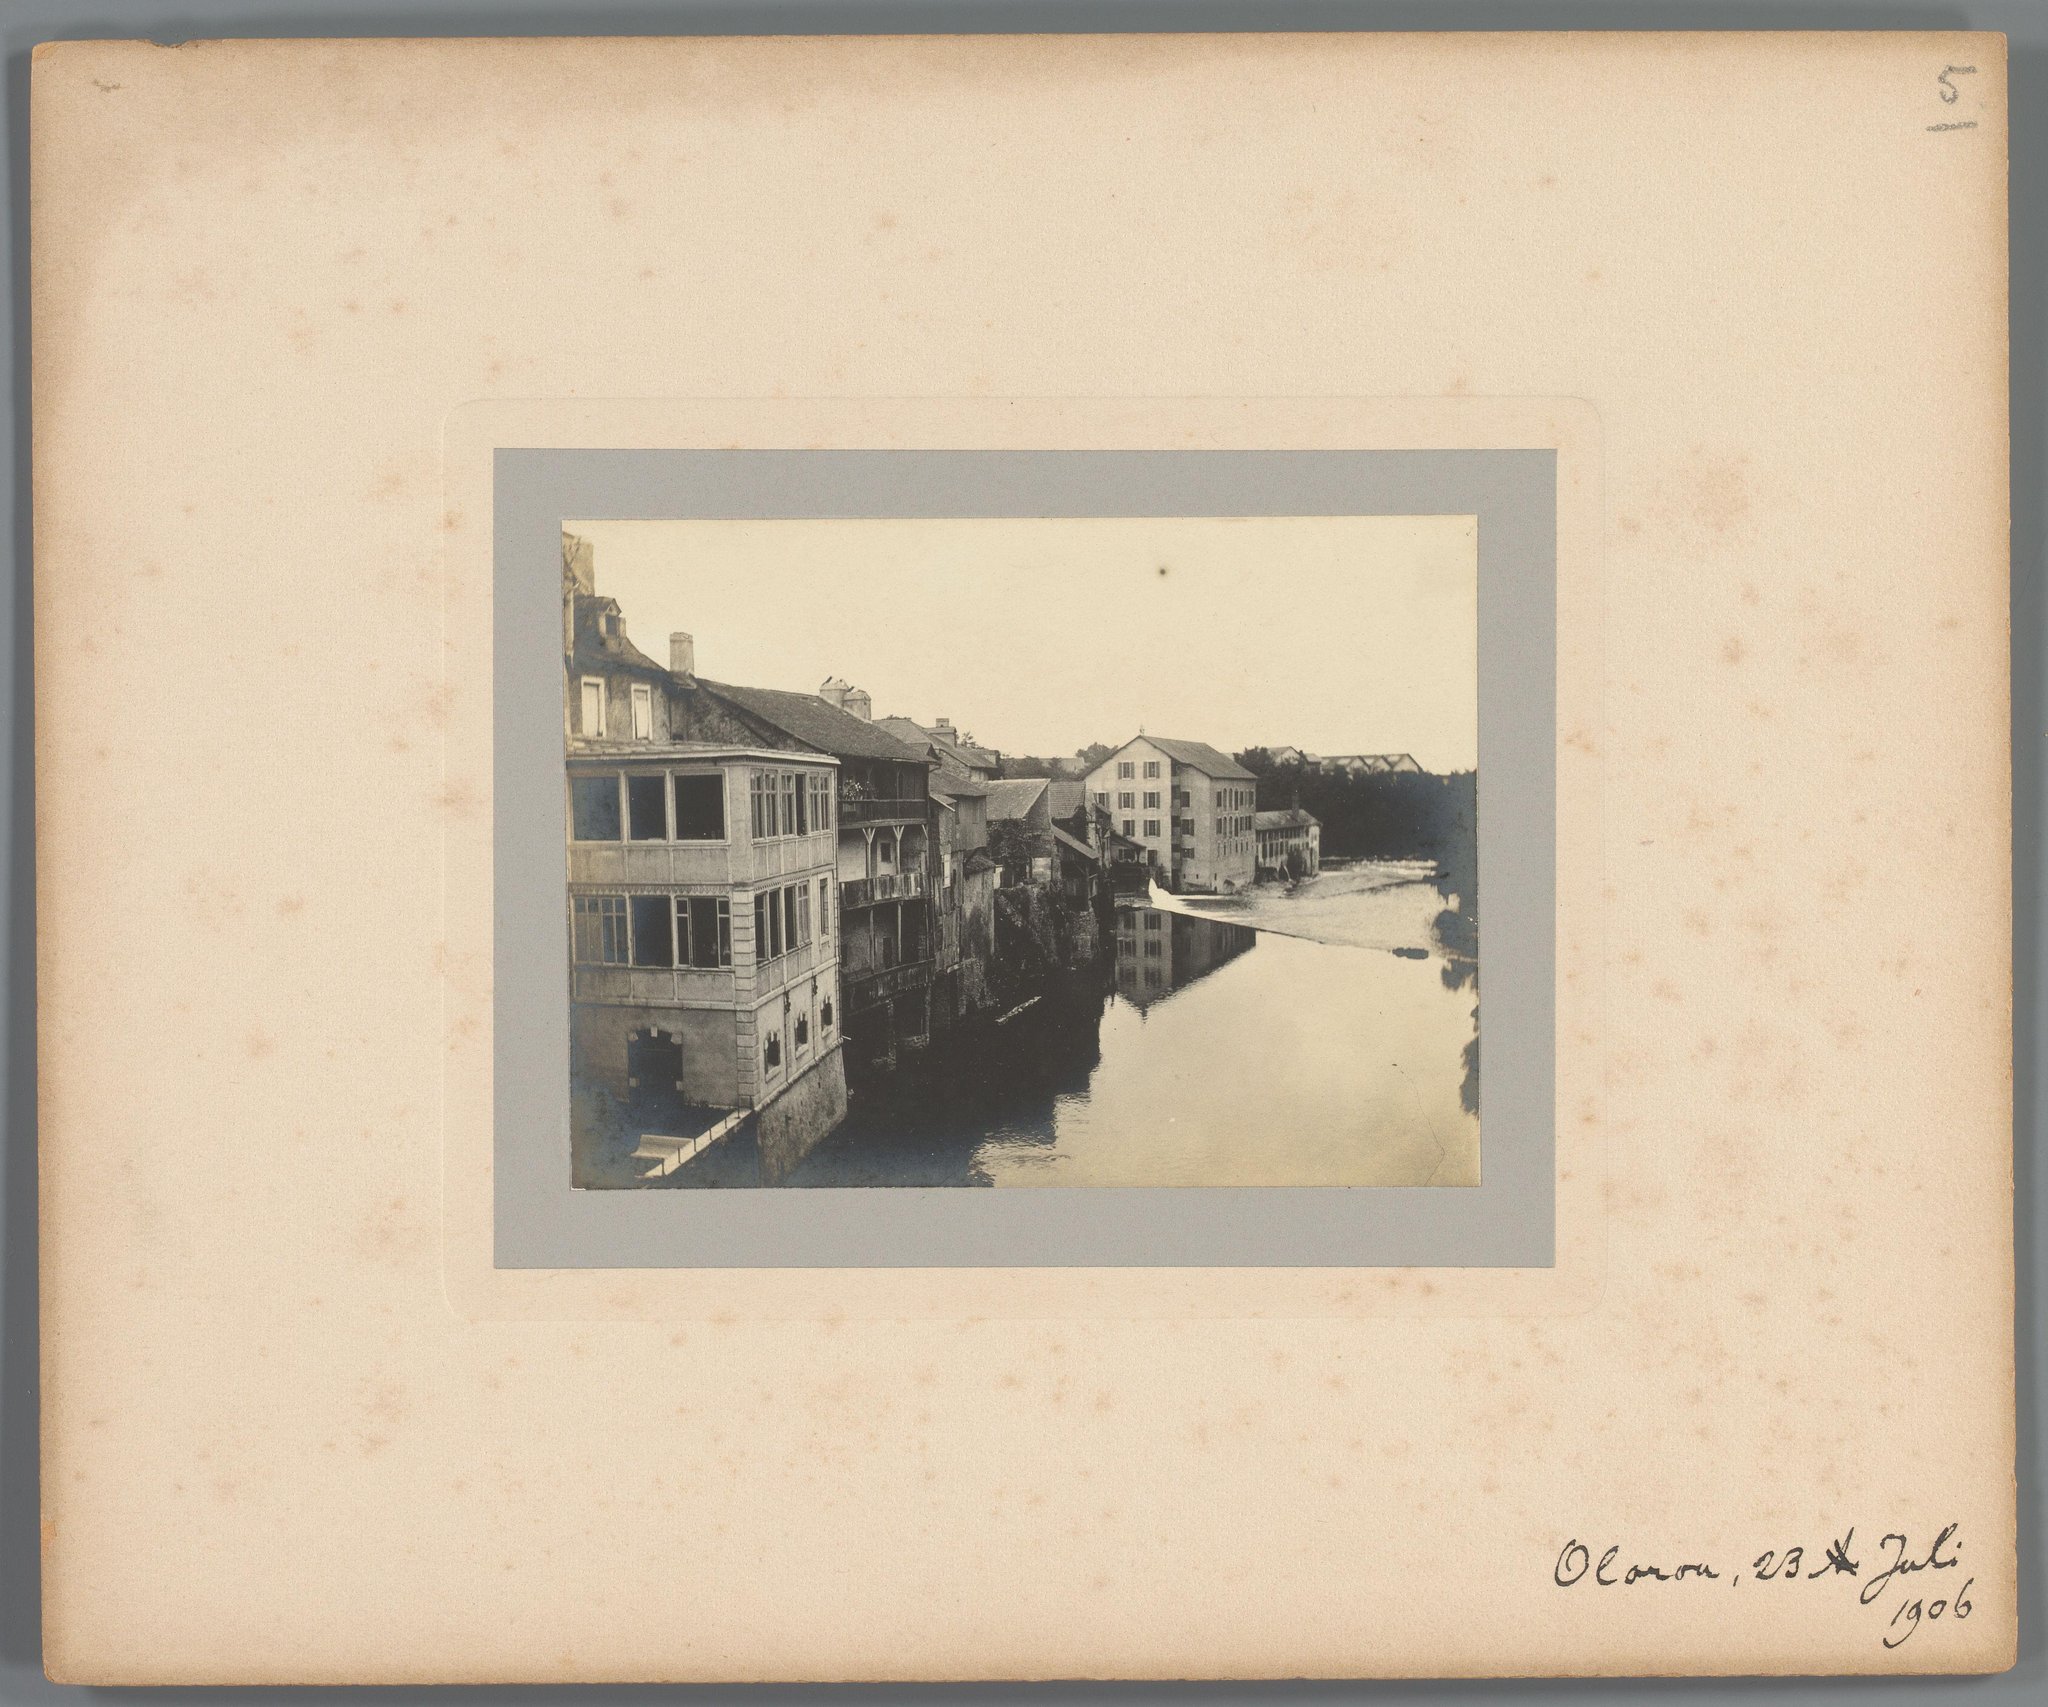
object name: photograph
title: Oloron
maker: françois buys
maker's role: advocaat, amateurfotograaf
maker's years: 1871-1934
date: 1906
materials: paper, cardboard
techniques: gelatin silver print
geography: oloron-sainte-marie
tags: urban housing, river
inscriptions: number: ‘5’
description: Deze foto maakt deel uit van een groep van 49 foto's.